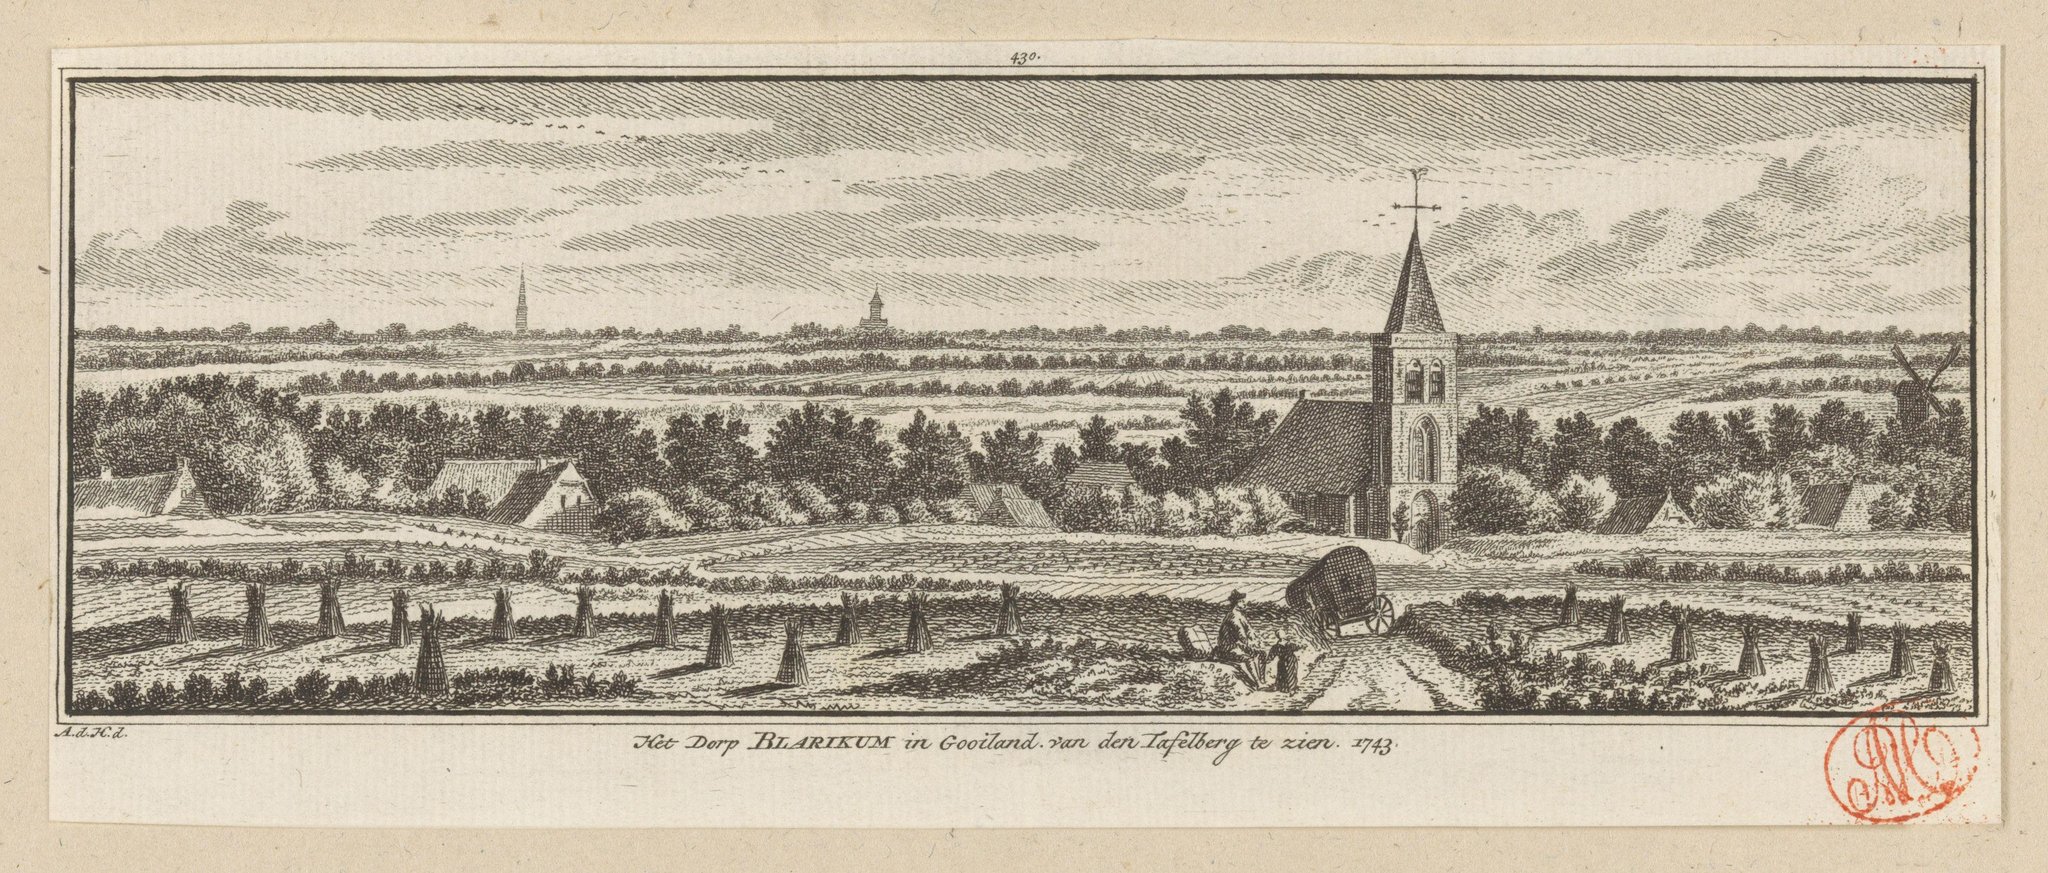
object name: print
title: Het dorp Blarikum in Gooiland. van den Tafelberg te zien. 1743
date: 1757-1792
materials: paper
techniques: engraving, etching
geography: haarlem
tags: prospect of village, silhouette of village, church (exterior)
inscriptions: collector's mark: Lugt 195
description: Prent ook gebruikt in: Het verheerlykt Nederland of kabinet van hedendaagsche gezigten van steden, dorpen (…). 9 delen. Amsterdam: Isaak Tirion en weduwe Isaak Tirion, 1745-1774, dl. 6 (1757), ill. 430. Of in: Nederlandsche tafereelen; of eene keurige verzameling van negen honderd fraaije gezigten van steden, dorpen, sloten, oudheden (….). 9 delen. Amsterdam: Jan de Groot, 1792, dl. 6, ill. 430. Uit welke druk het huidige exemplaar precies komt is niet na te gaan.